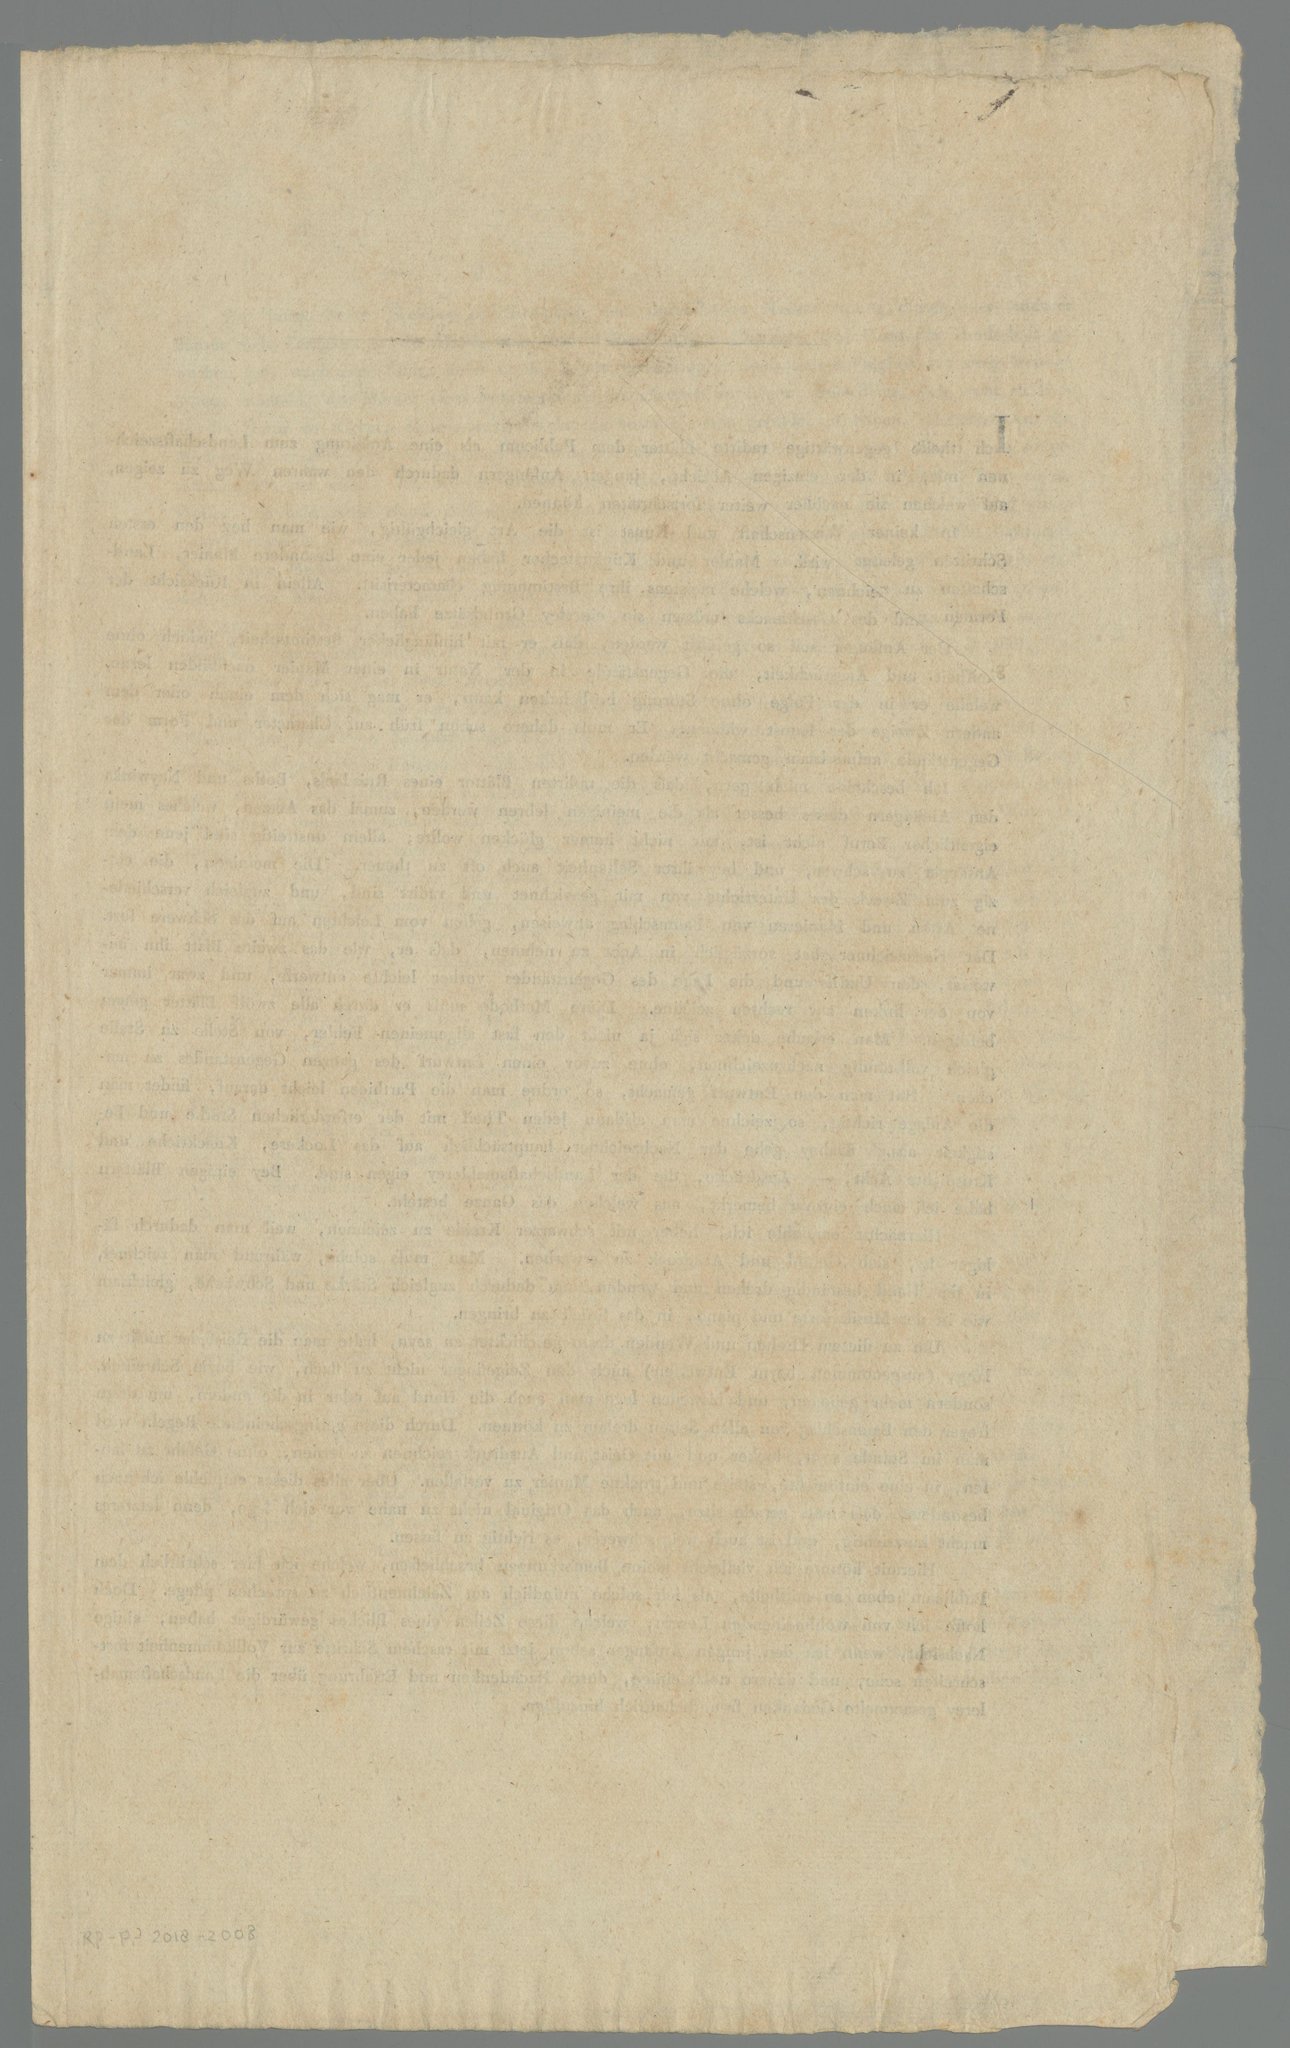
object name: text sheet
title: Studies voor het tekenen van landschappen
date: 1802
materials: paper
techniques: letterpress printing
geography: dresden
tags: single printed leaf: broadsheet, leaflet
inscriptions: date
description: De inleiding (en aanleiding) tot een serie prenten gegraveerd door Johann Christian Klengel en hier beschreven. Dit stuk tekst hoort bij de uitgave: Klengel, Johann Christian. Principes de Dessein pour Les Paysages par J.C. Klengel, professeur de l'Academie Electorale de Peinture a Dresde. Se vend chez Henry Rittner au Magazin des Beaux Arts Rue de Chateau no. 329 a Dresde. Dresden: Heinrich Rittner, 1802.